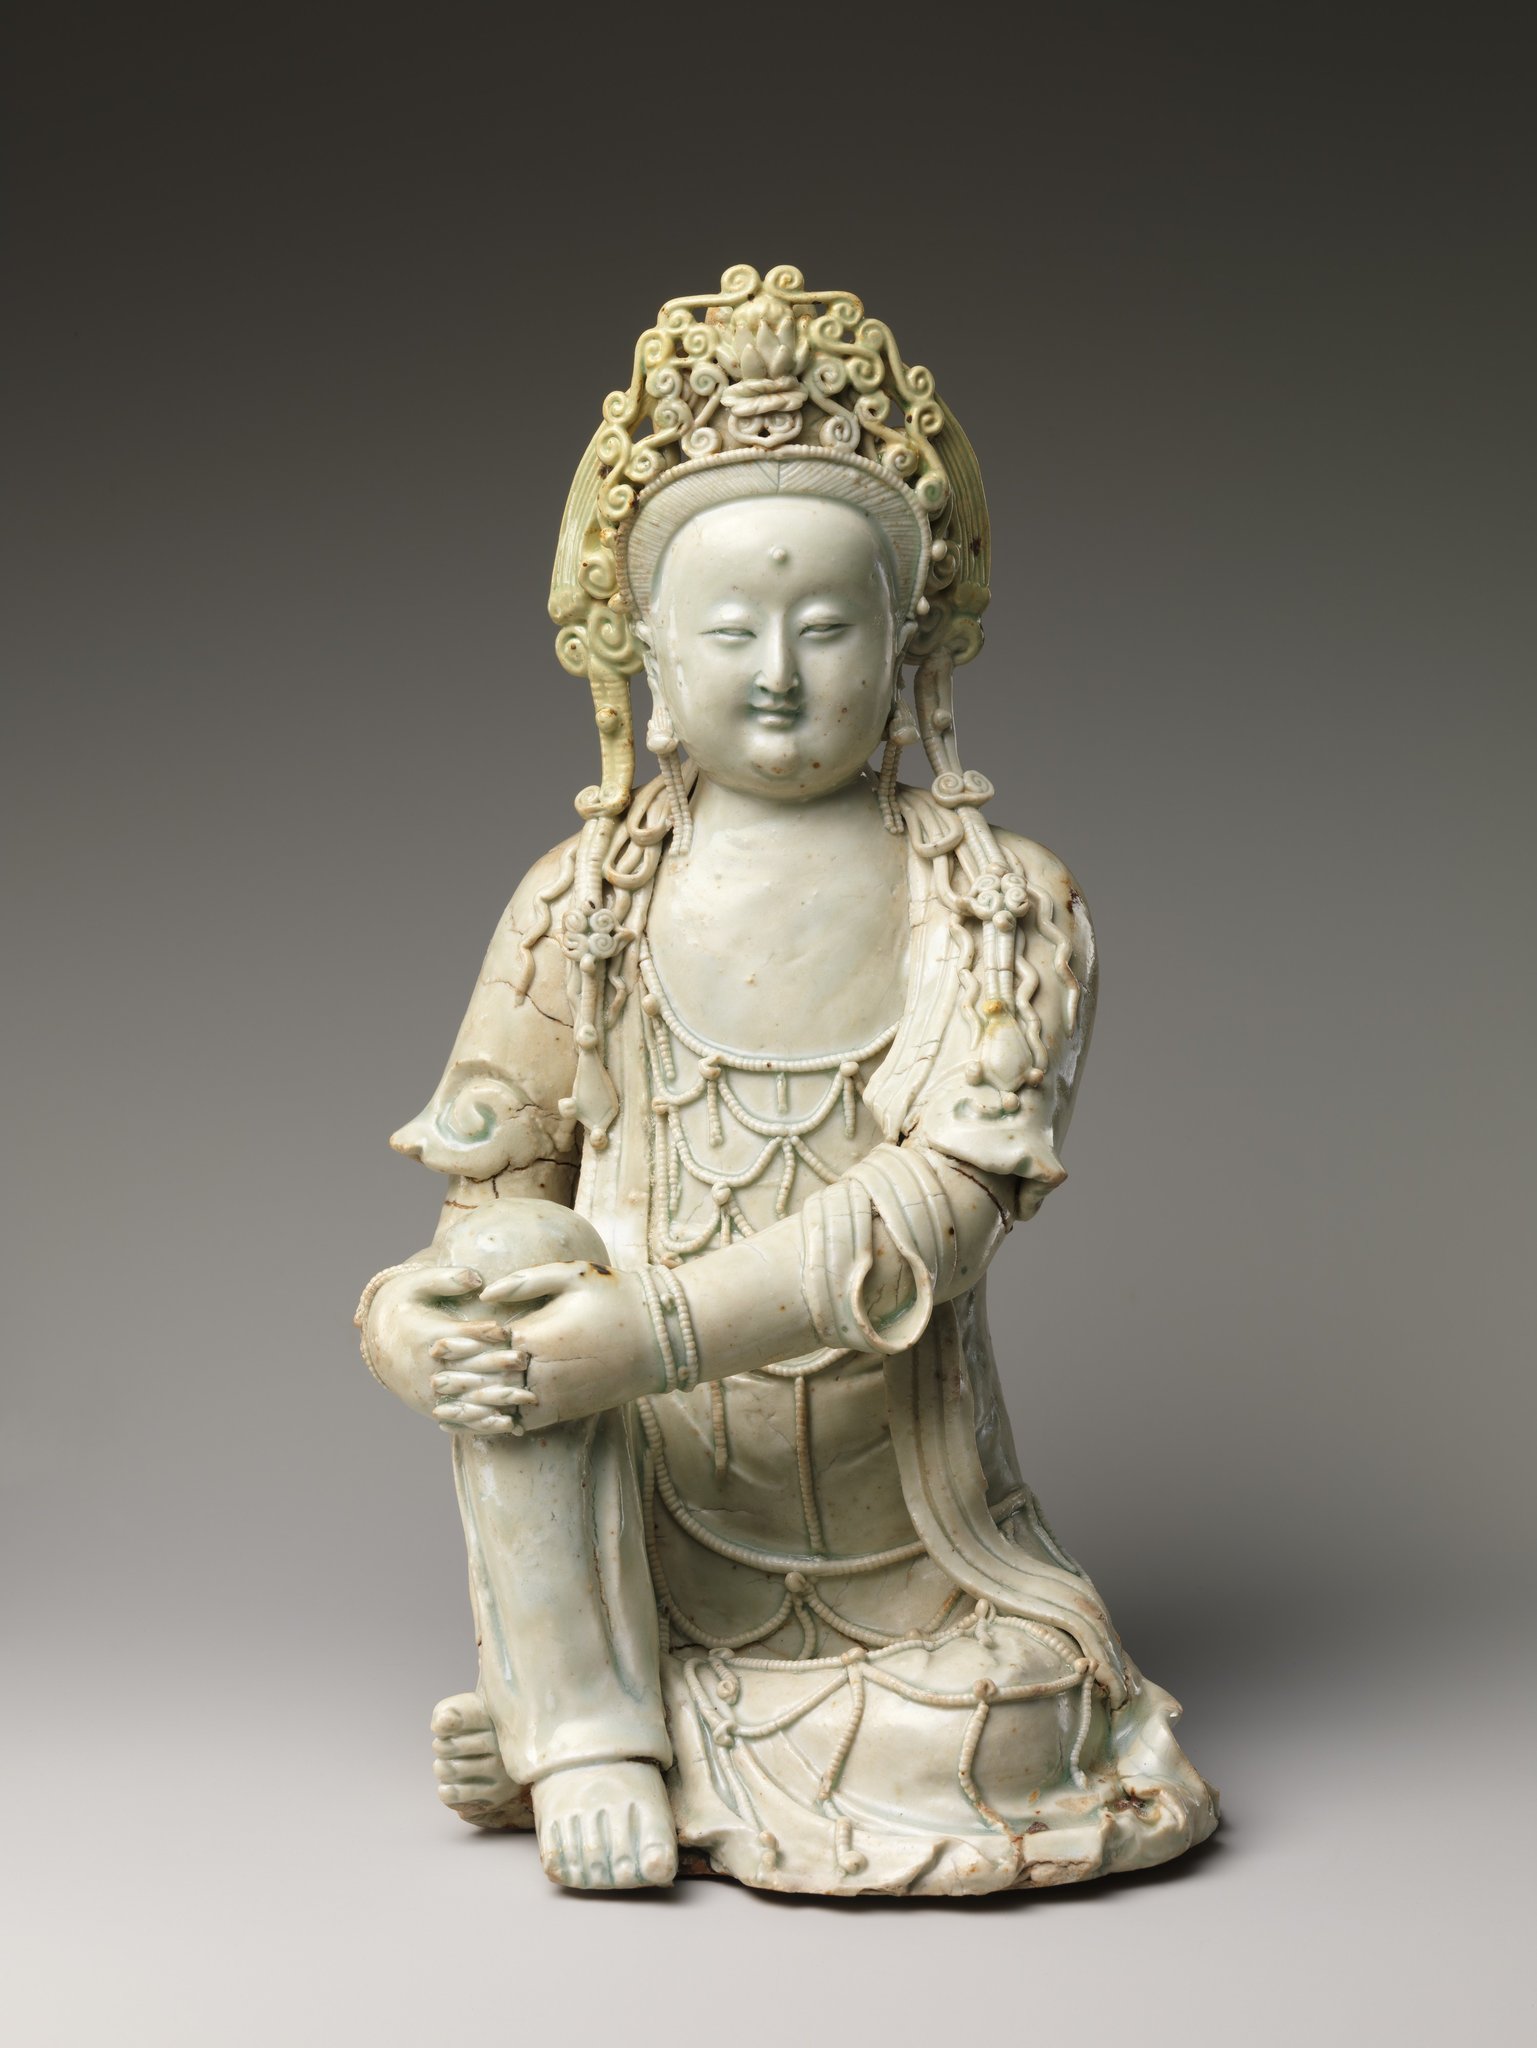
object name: figure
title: Bodhisattva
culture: chinese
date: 1301-1400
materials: porcelain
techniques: glazing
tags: bodhisattvas